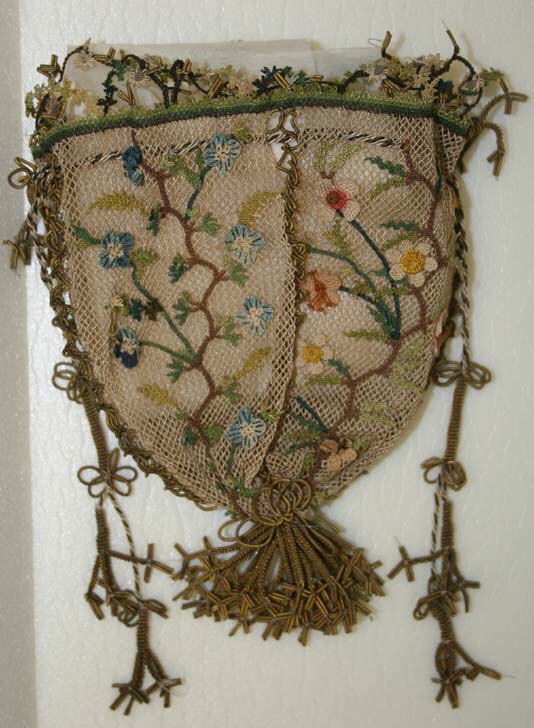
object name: bag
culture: european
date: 1701-1800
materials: silk